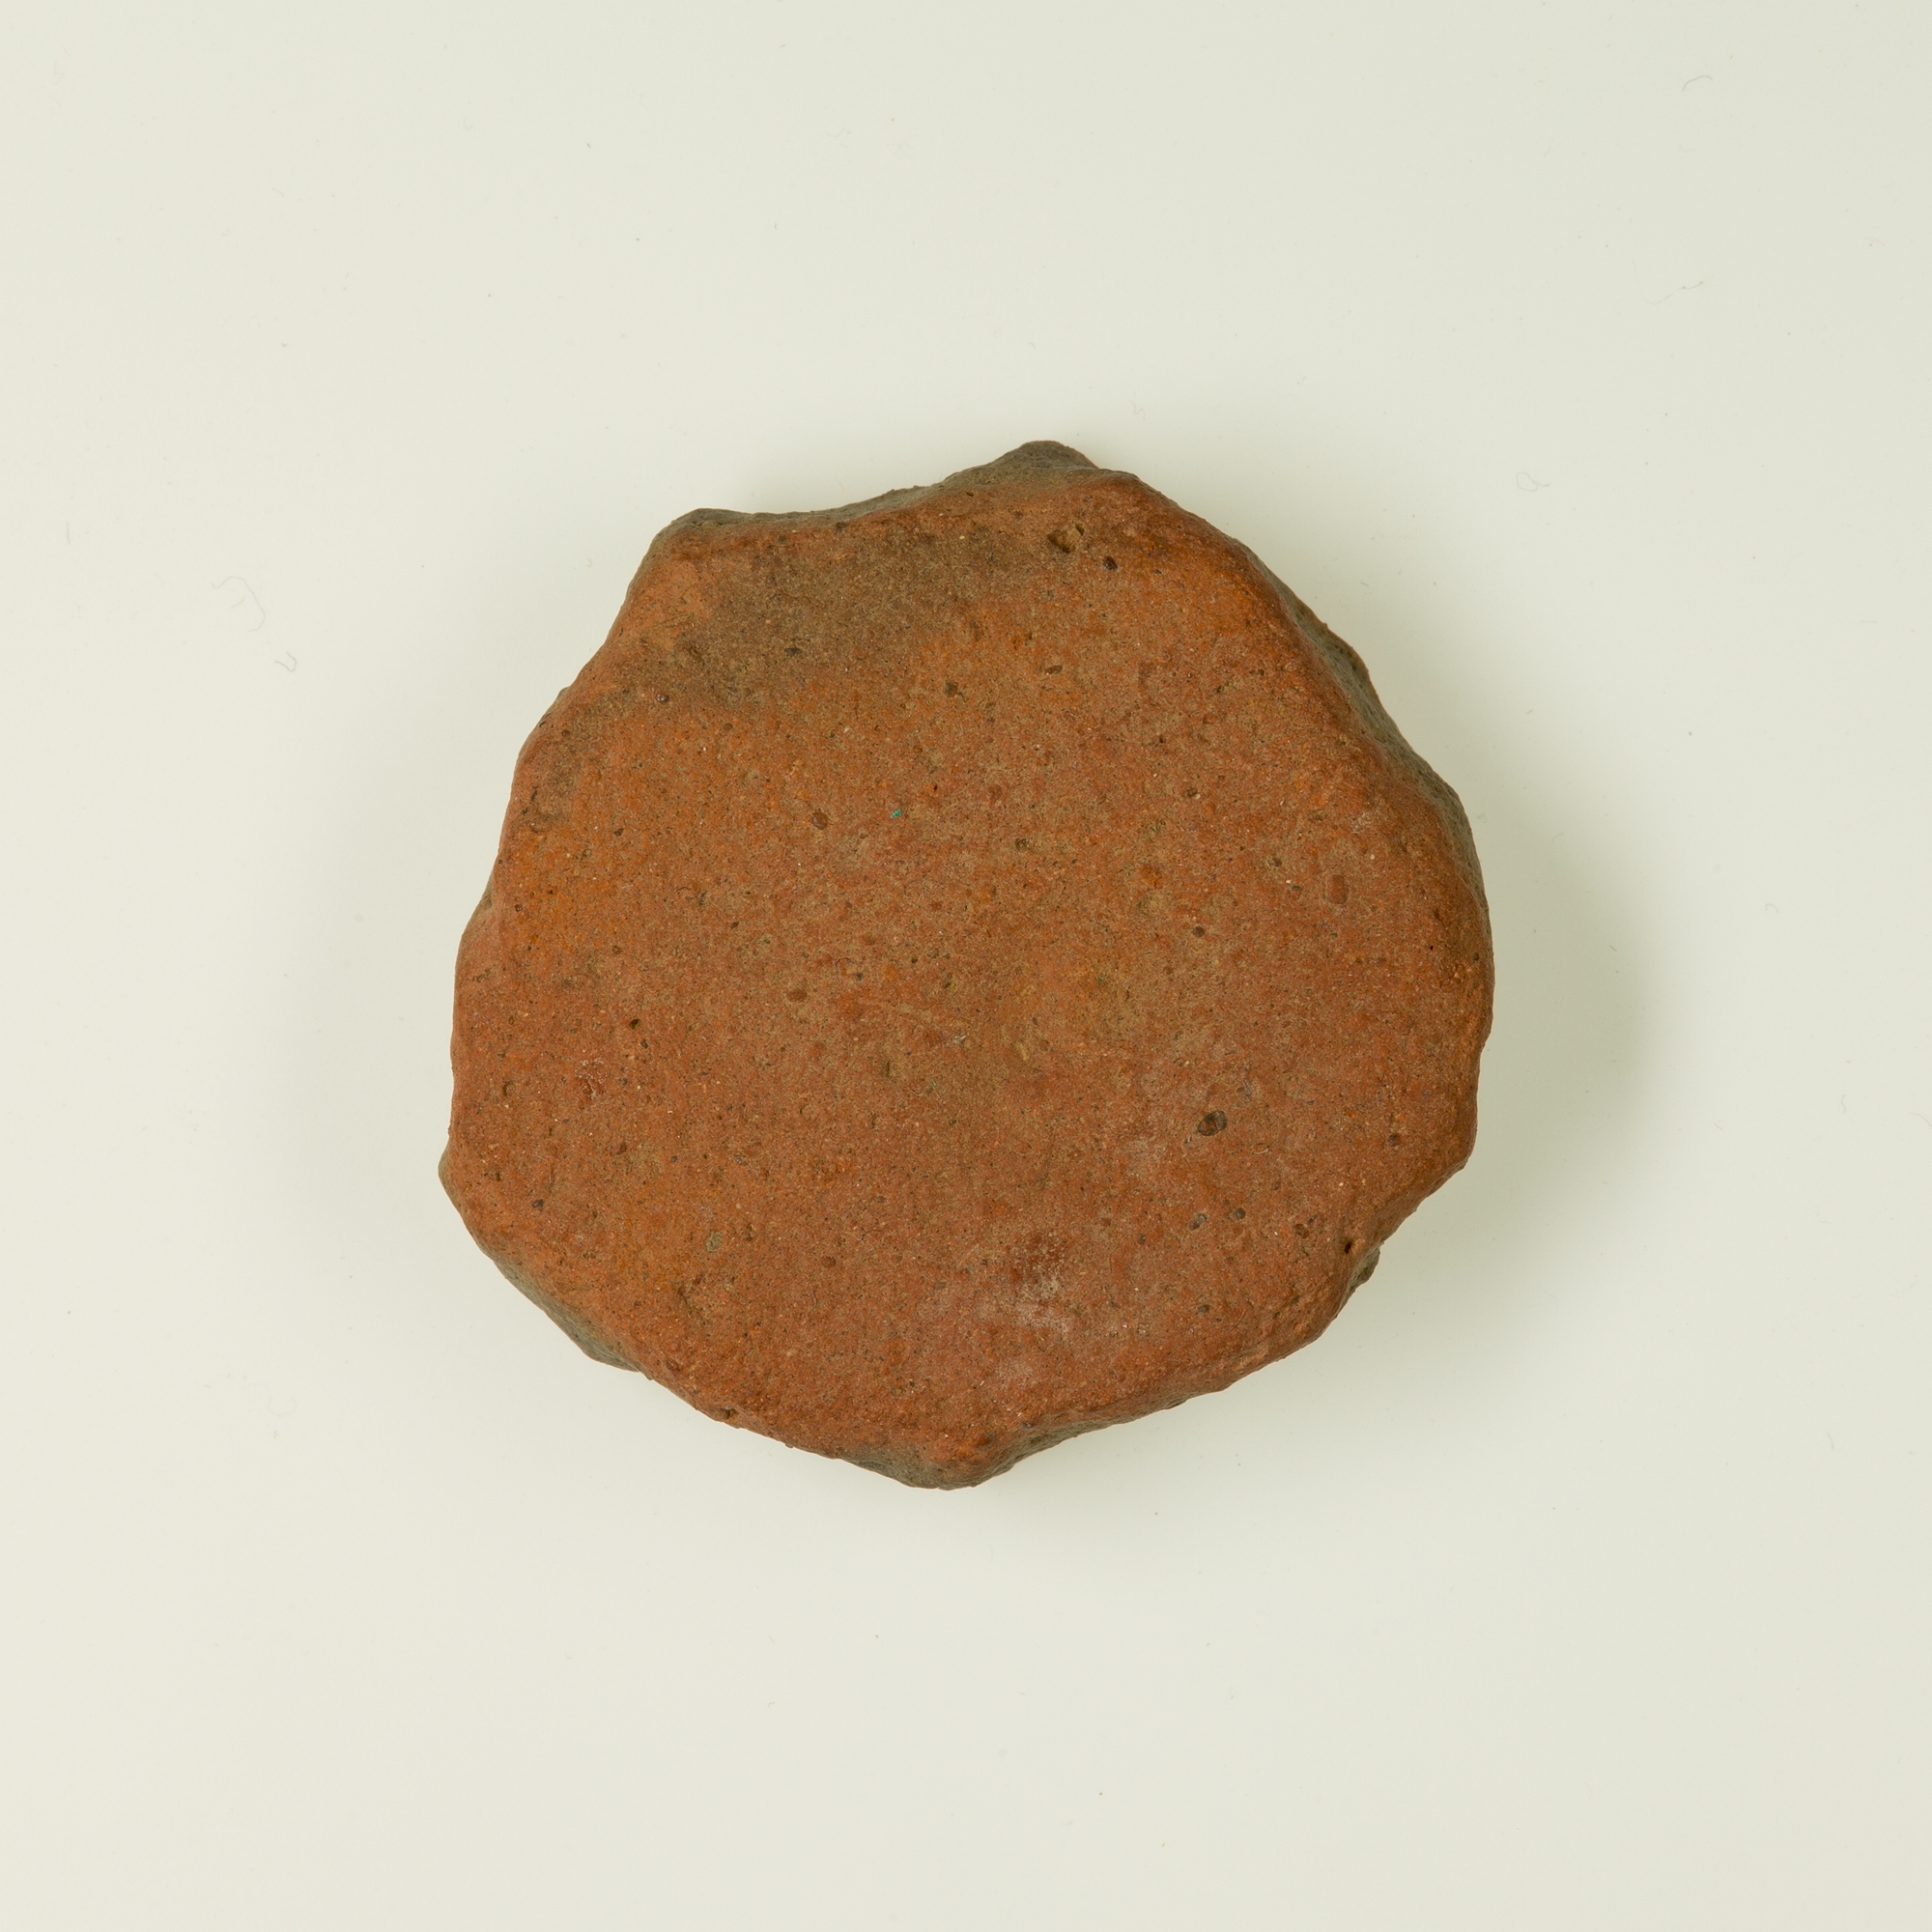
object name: spool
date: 1295-1070 BCE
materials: pottery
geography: egypt